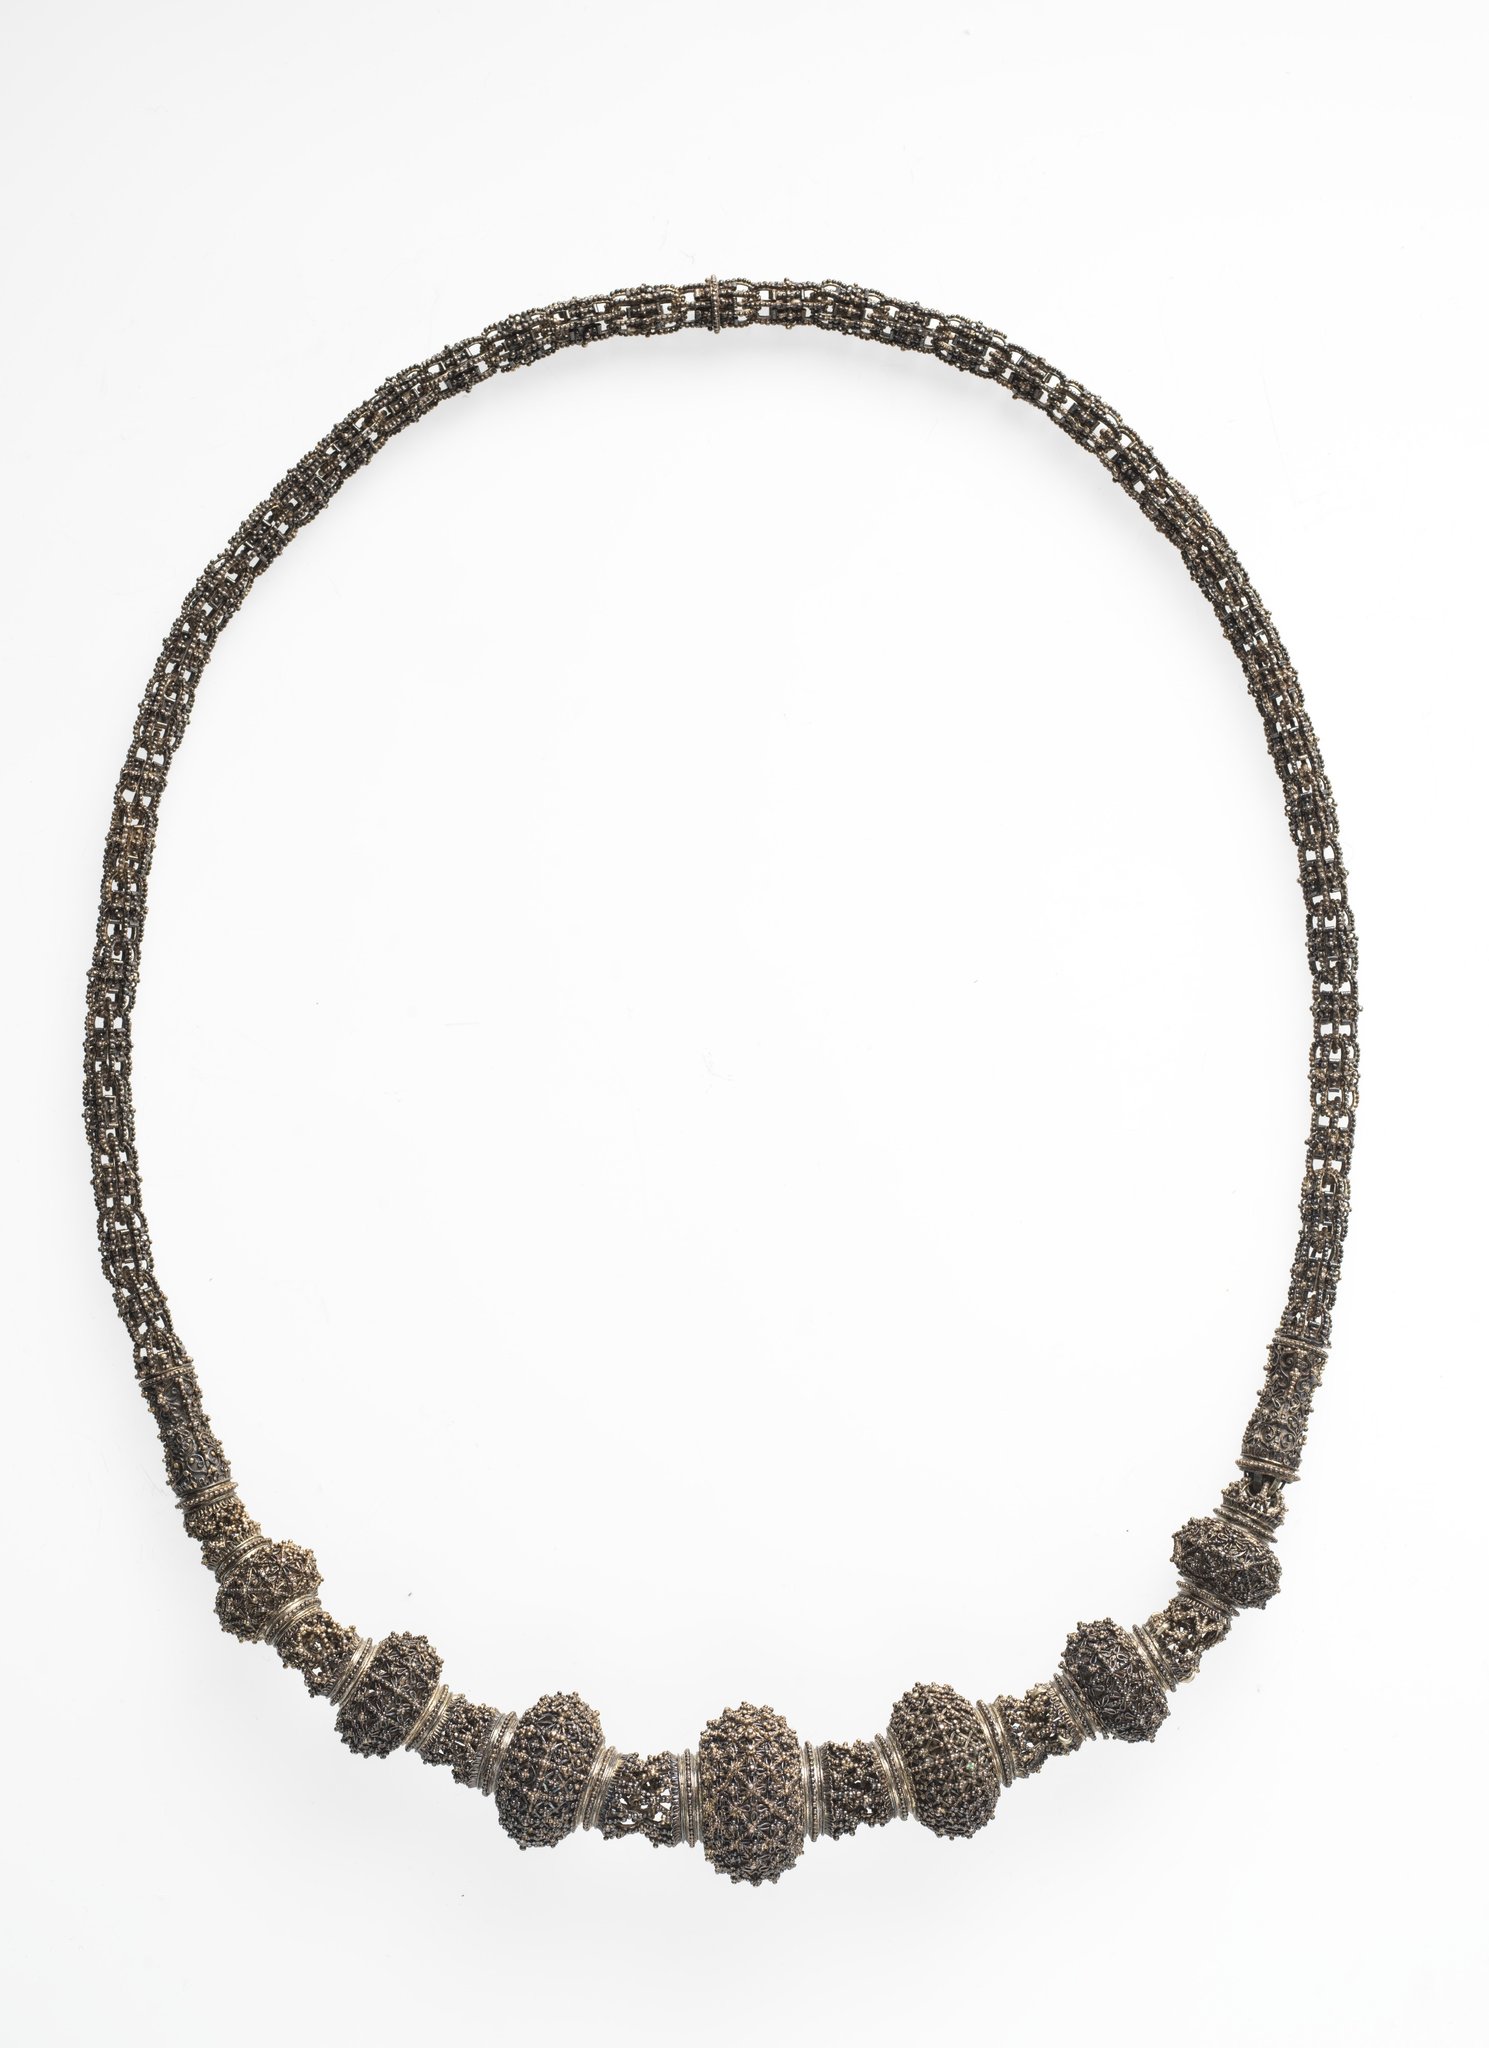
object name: necklace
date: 1701-1900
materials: silver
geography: sri lanka